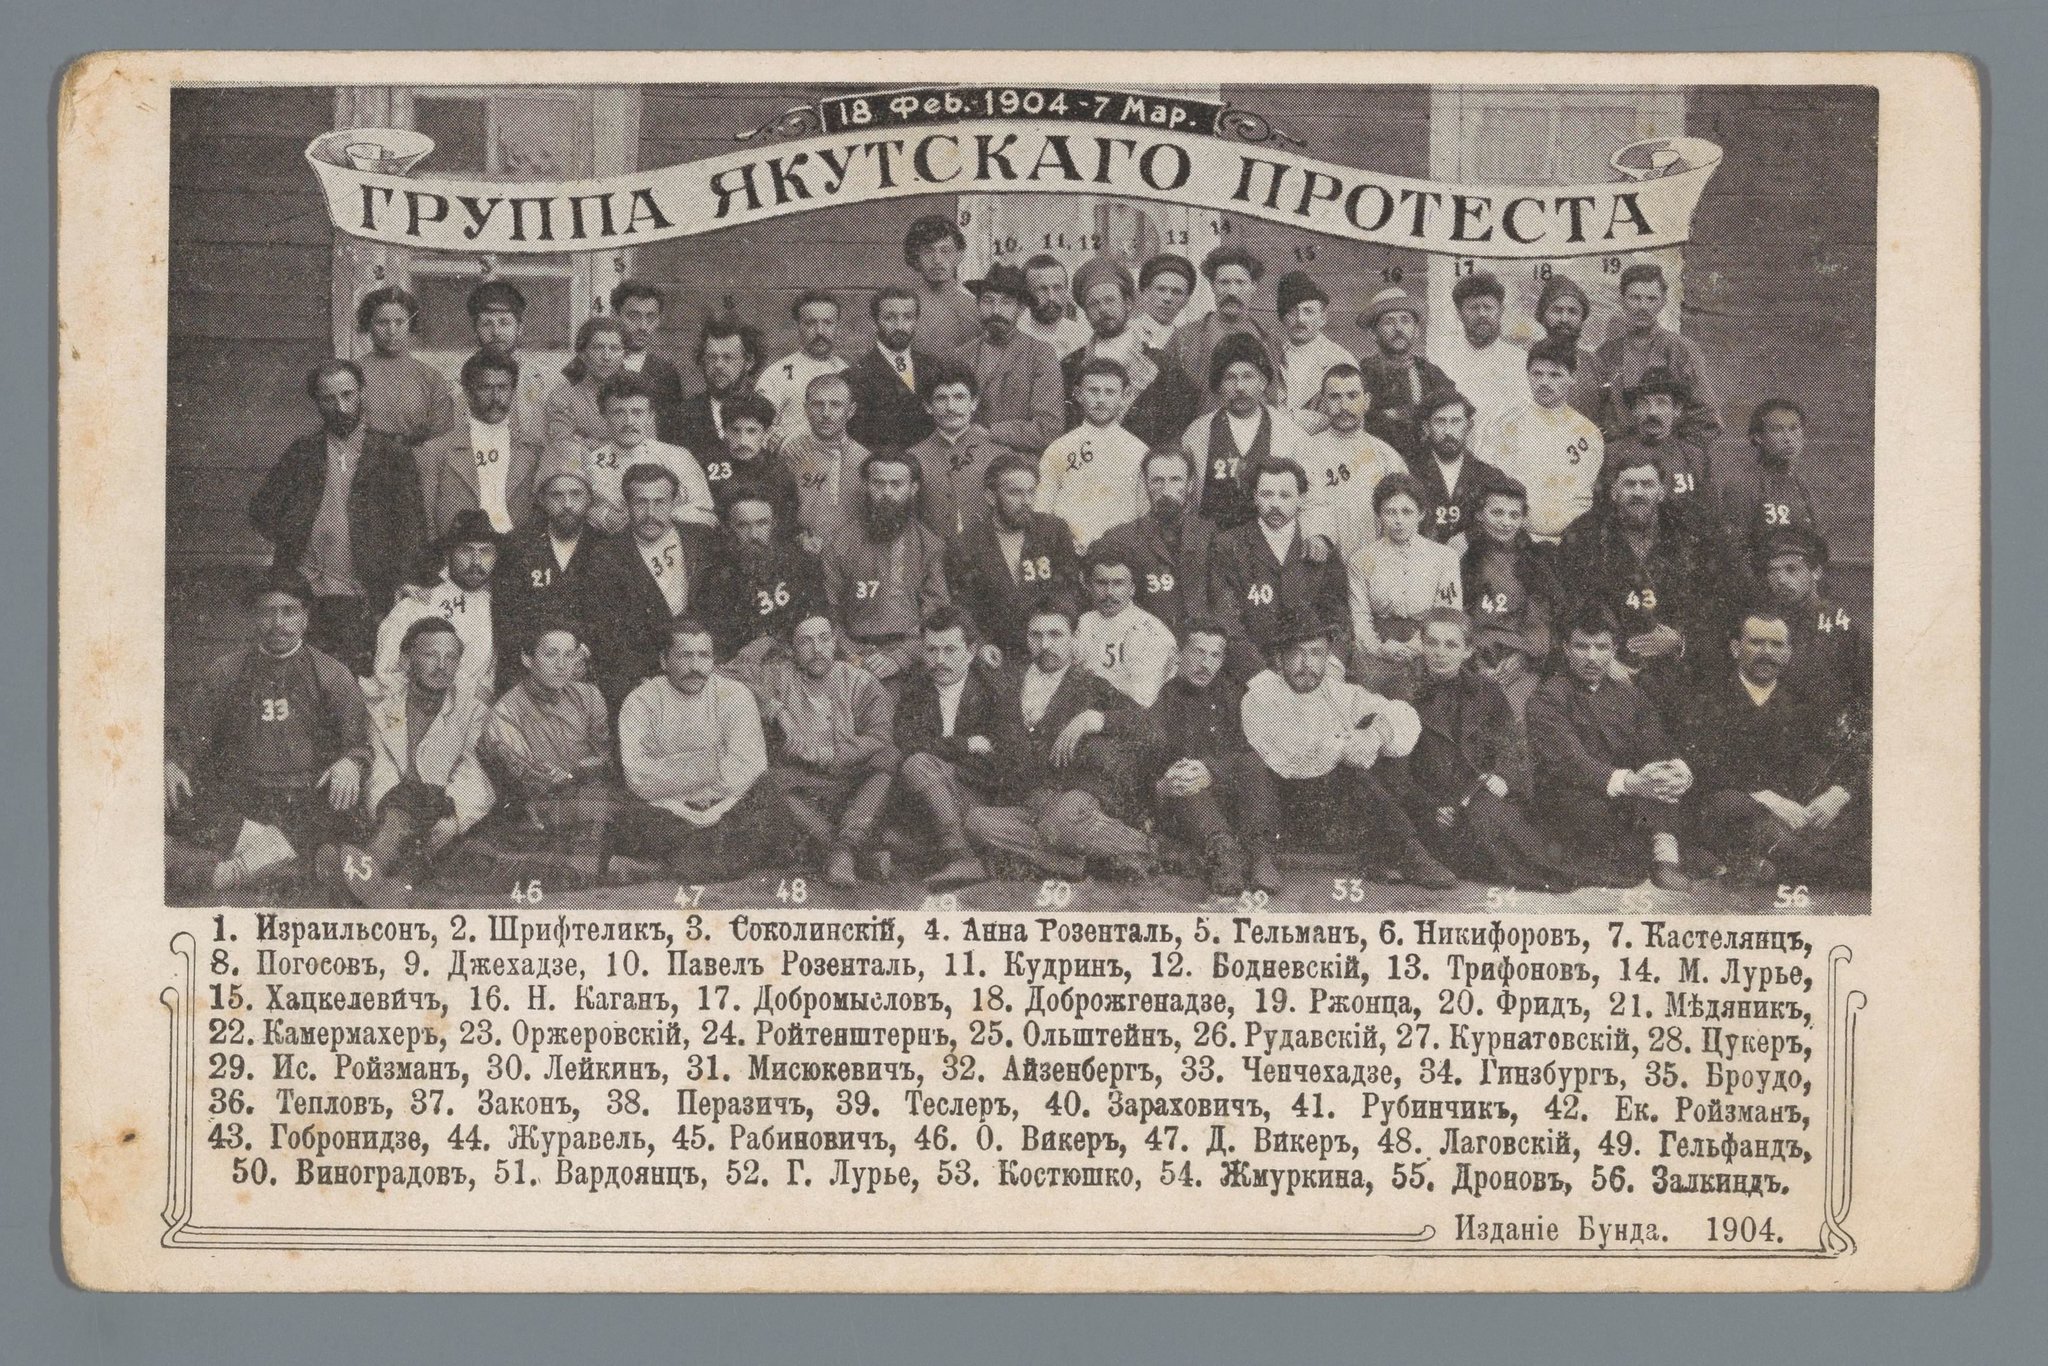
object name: ansichtkaart, prentbriefkaart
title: Groepsportret van leden van een protestbeweging te Jakoetsk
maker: Anonymous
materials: paper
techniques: autotype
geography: russia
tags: anonymous historical persons portrayed in a group, in a group-portrait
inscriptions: number: ‘1 (...) 56.’